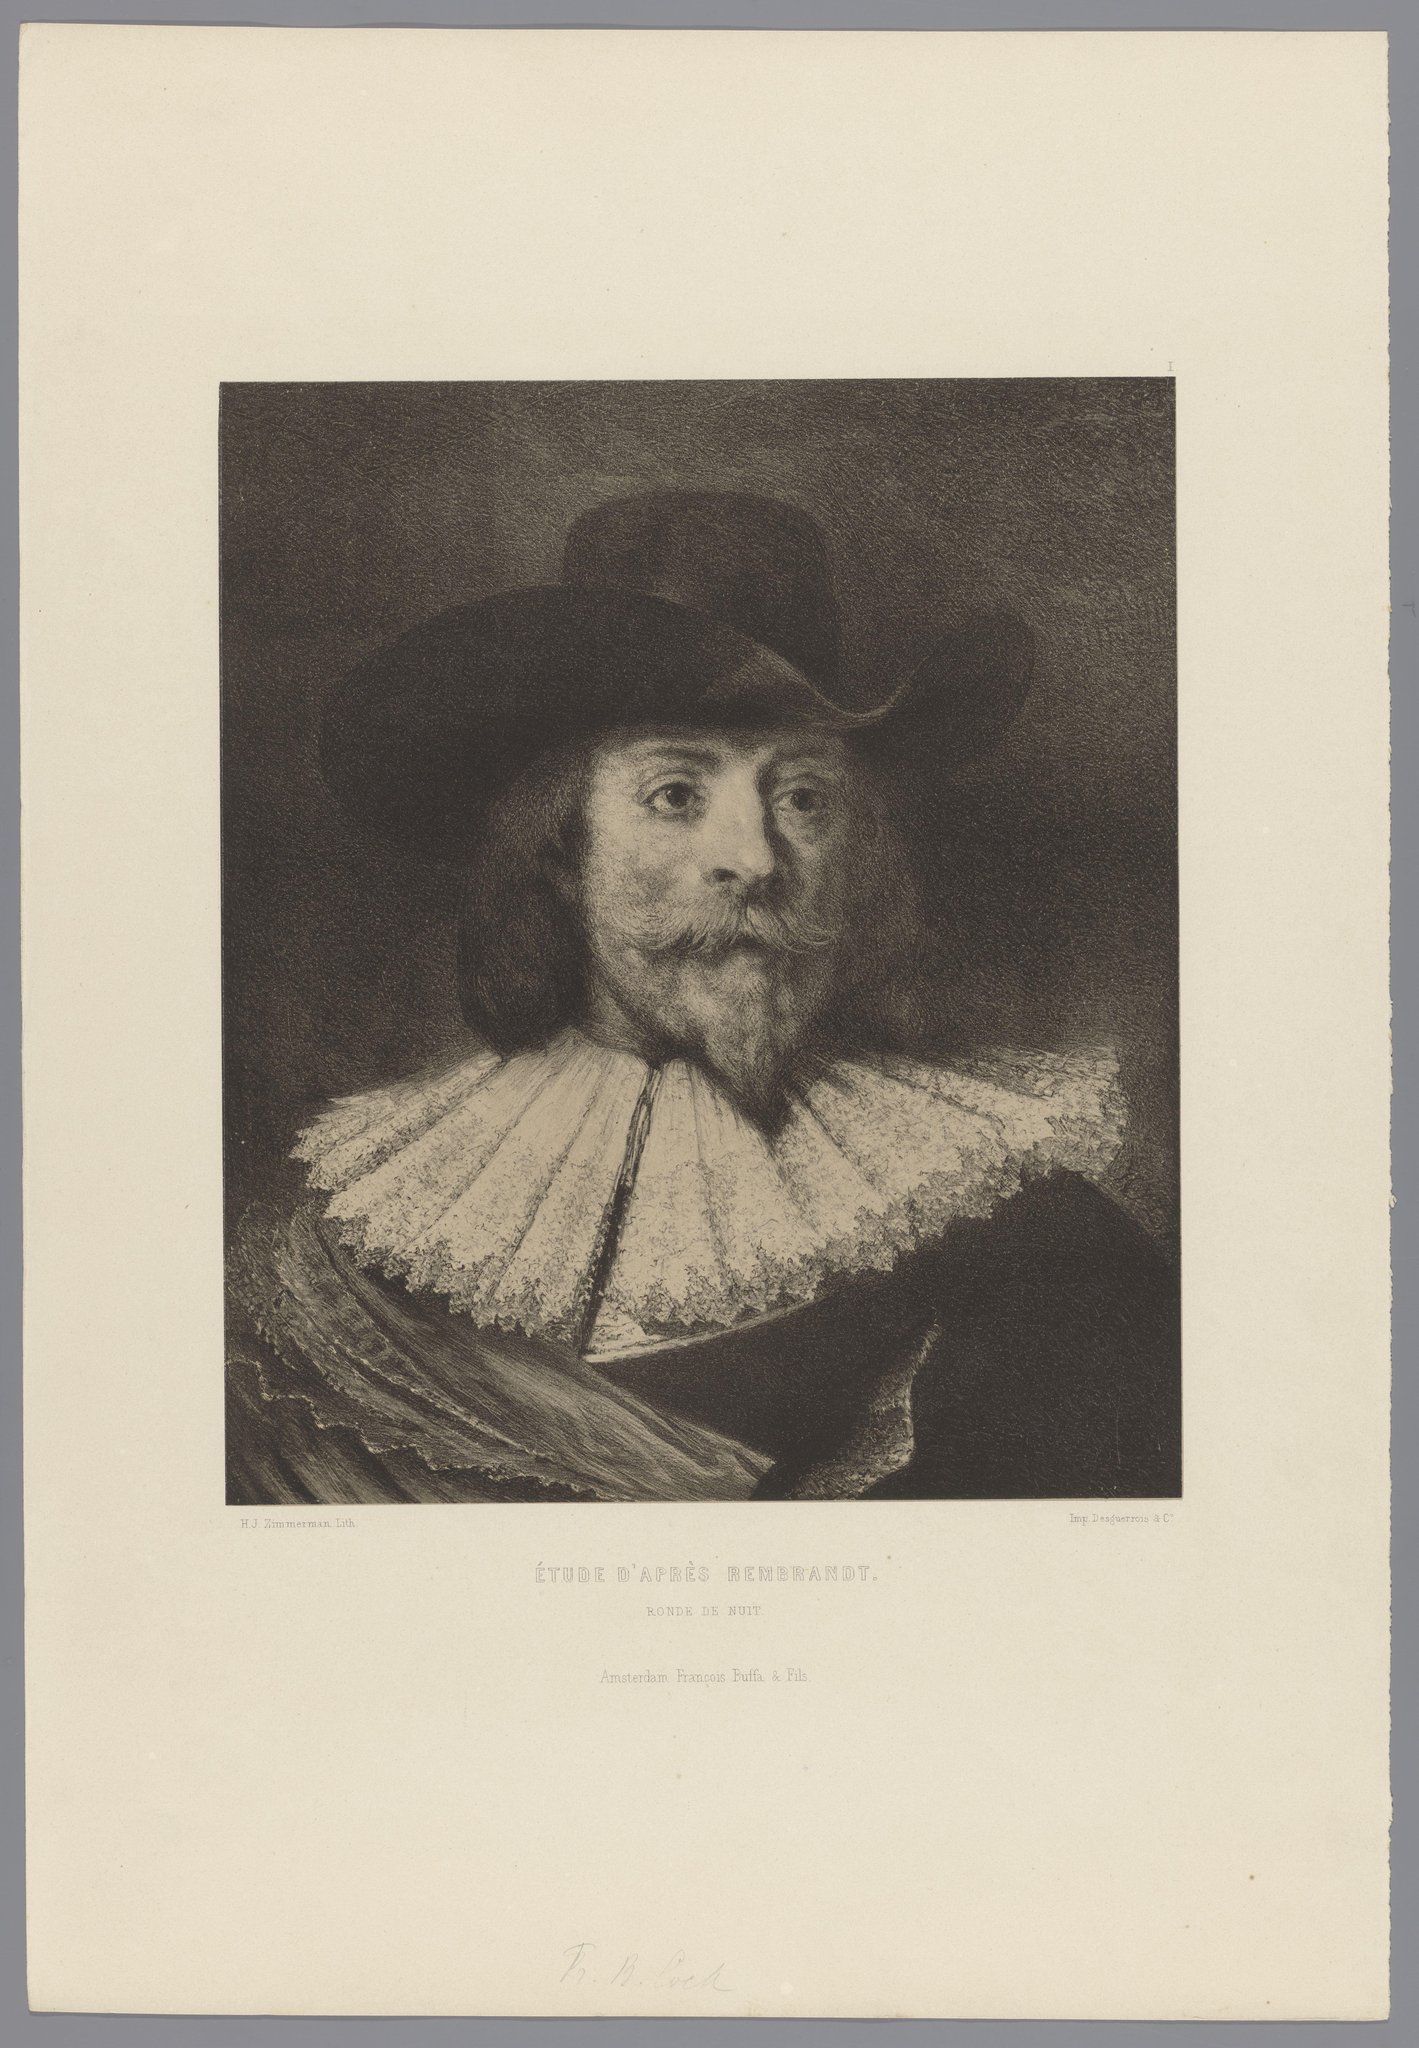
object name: print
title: Etudes d`après Rembrandt et autres maîtres hollandais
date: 1859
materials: paper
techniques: lithograph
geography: amsterdam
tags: leiden, amsterdam, painter, print maker, draughtsman, rembrandt van rijn, picture, painting, historical persons (+ (full) bust portrait)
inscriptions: collector's mark: Lugt 2165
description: Detail uit Het korporaalschap van kapitein Frans Banning Cocq door Rembrandt. Deze prent maakt deel uit van een omslag met zeven prenten.